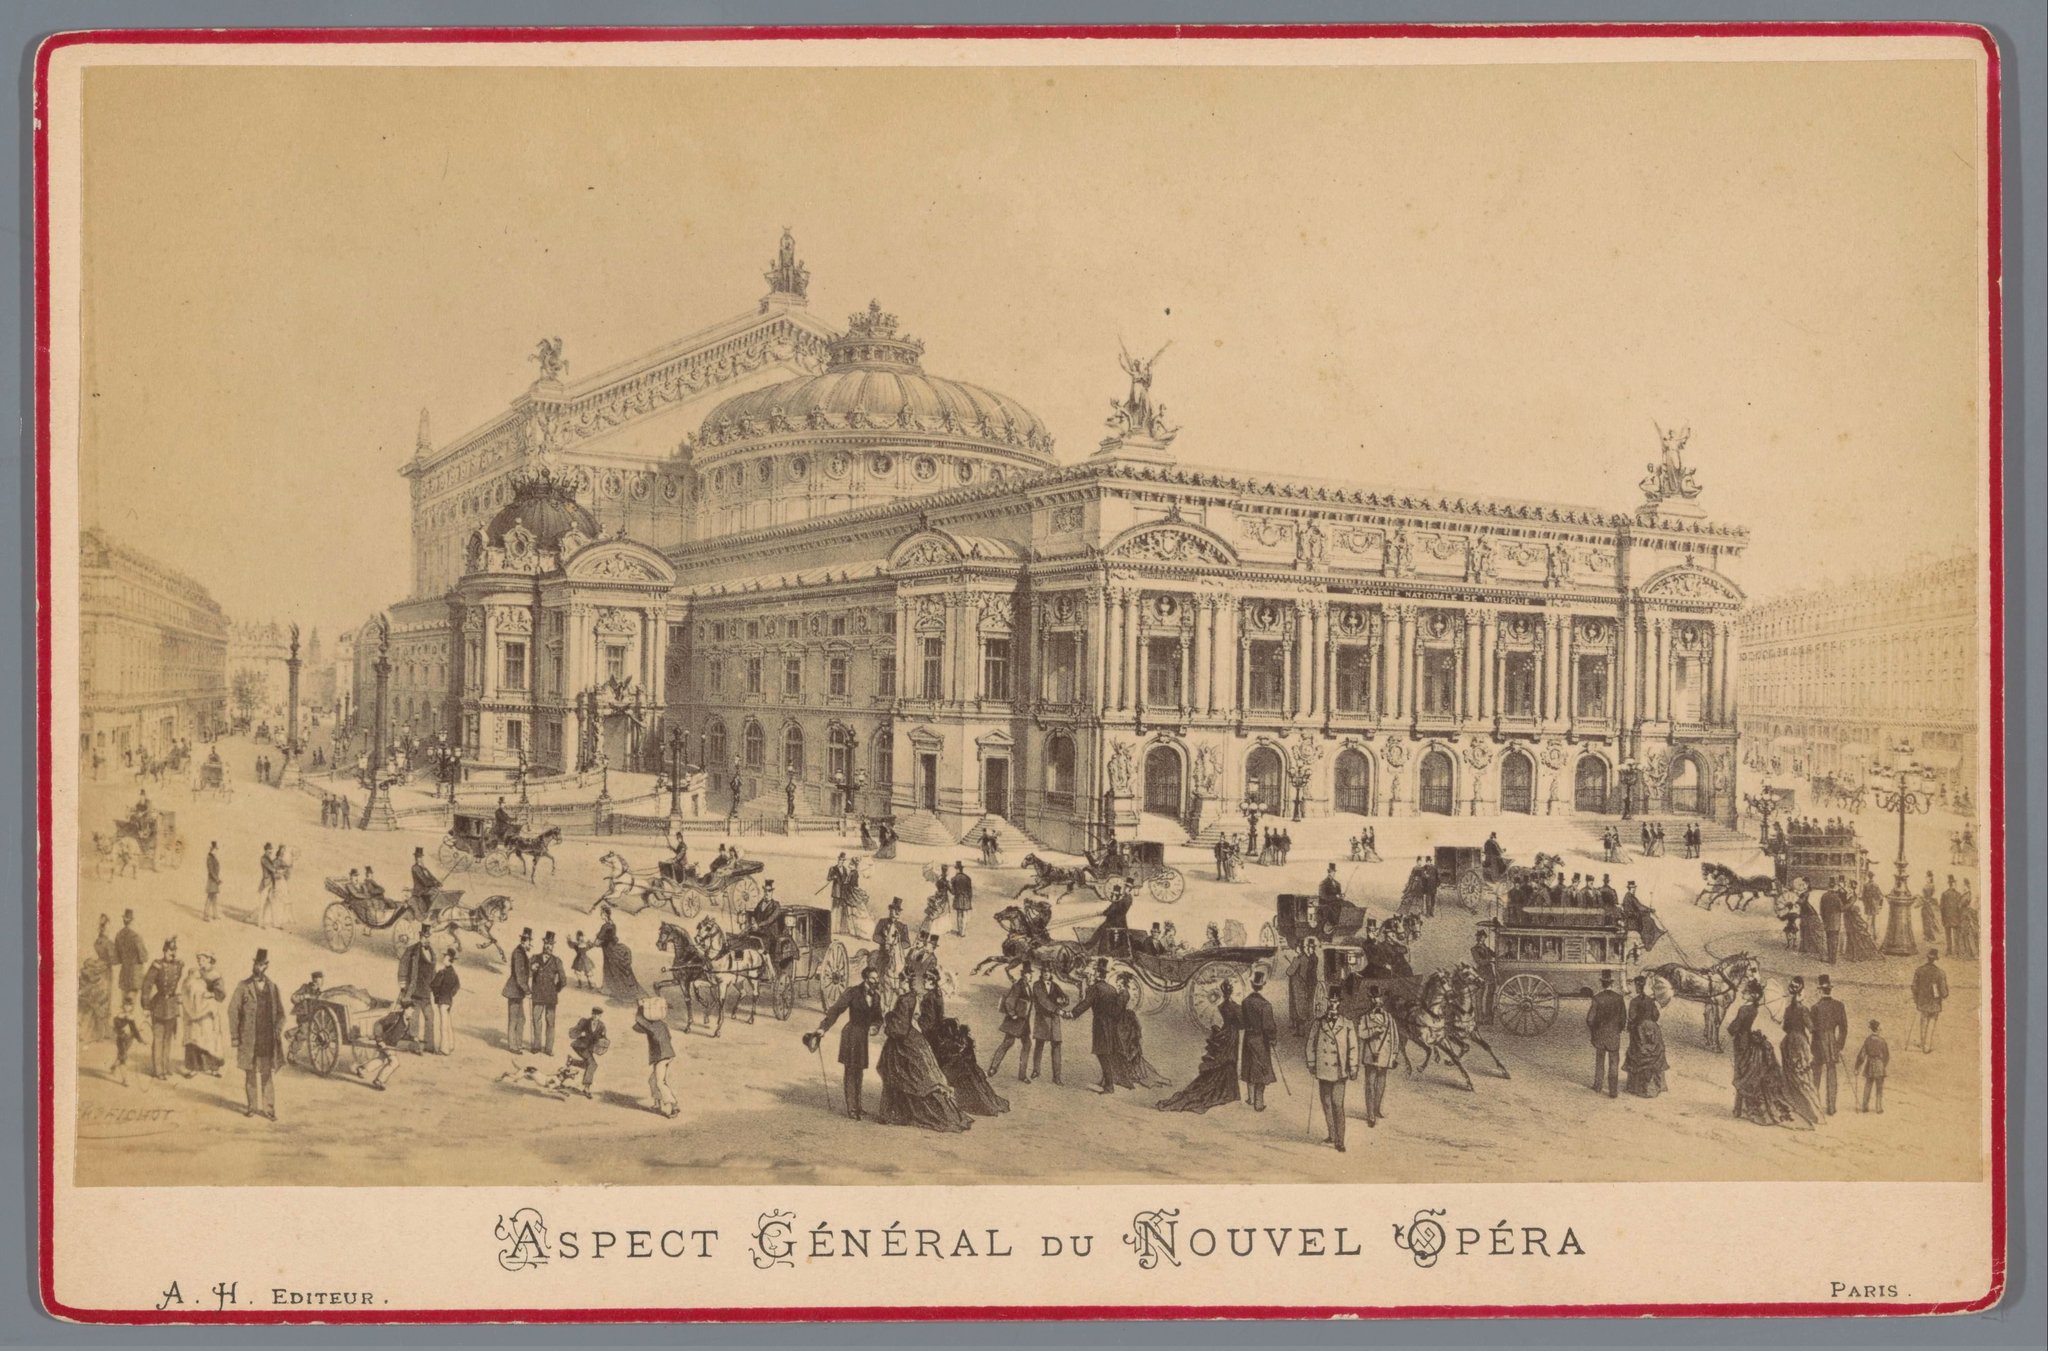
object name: photograph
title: Aspect Général du Nouvel Opéra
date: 1875-1885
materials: cardboard, photographic support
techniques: albumen print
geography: paris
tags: façade (of house or building), opera house